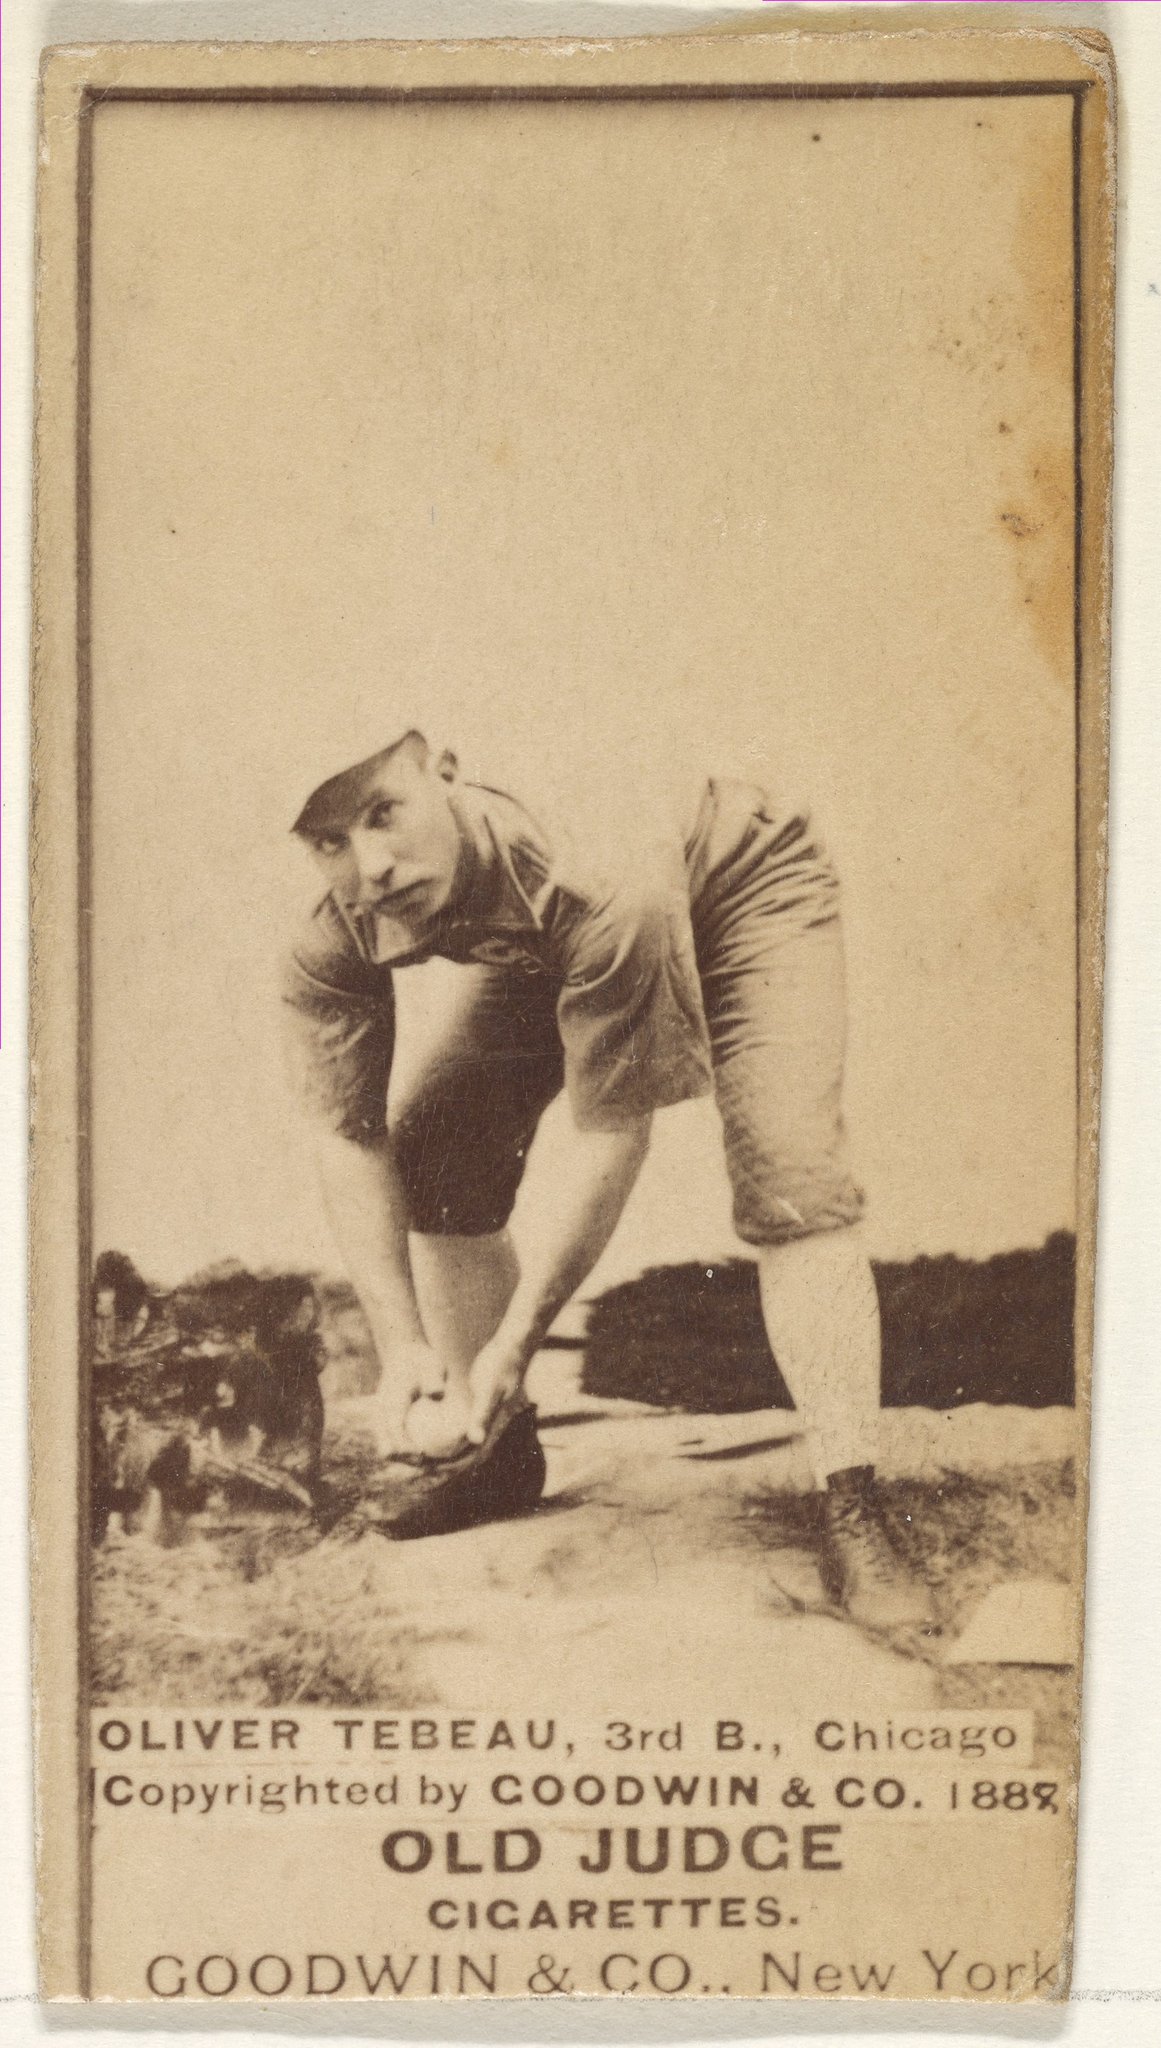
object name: baseball card, photograph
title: Oliver Wendell "Patsy" Tebeau, 3rd Base, Chicago, from the Old Judge series (N172) for Old Judge Cigarettes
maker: goodwin & company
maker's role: publisher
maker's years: 1850-1950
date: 1888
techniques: albumen silver print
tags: men,portraits,baseball,athletes